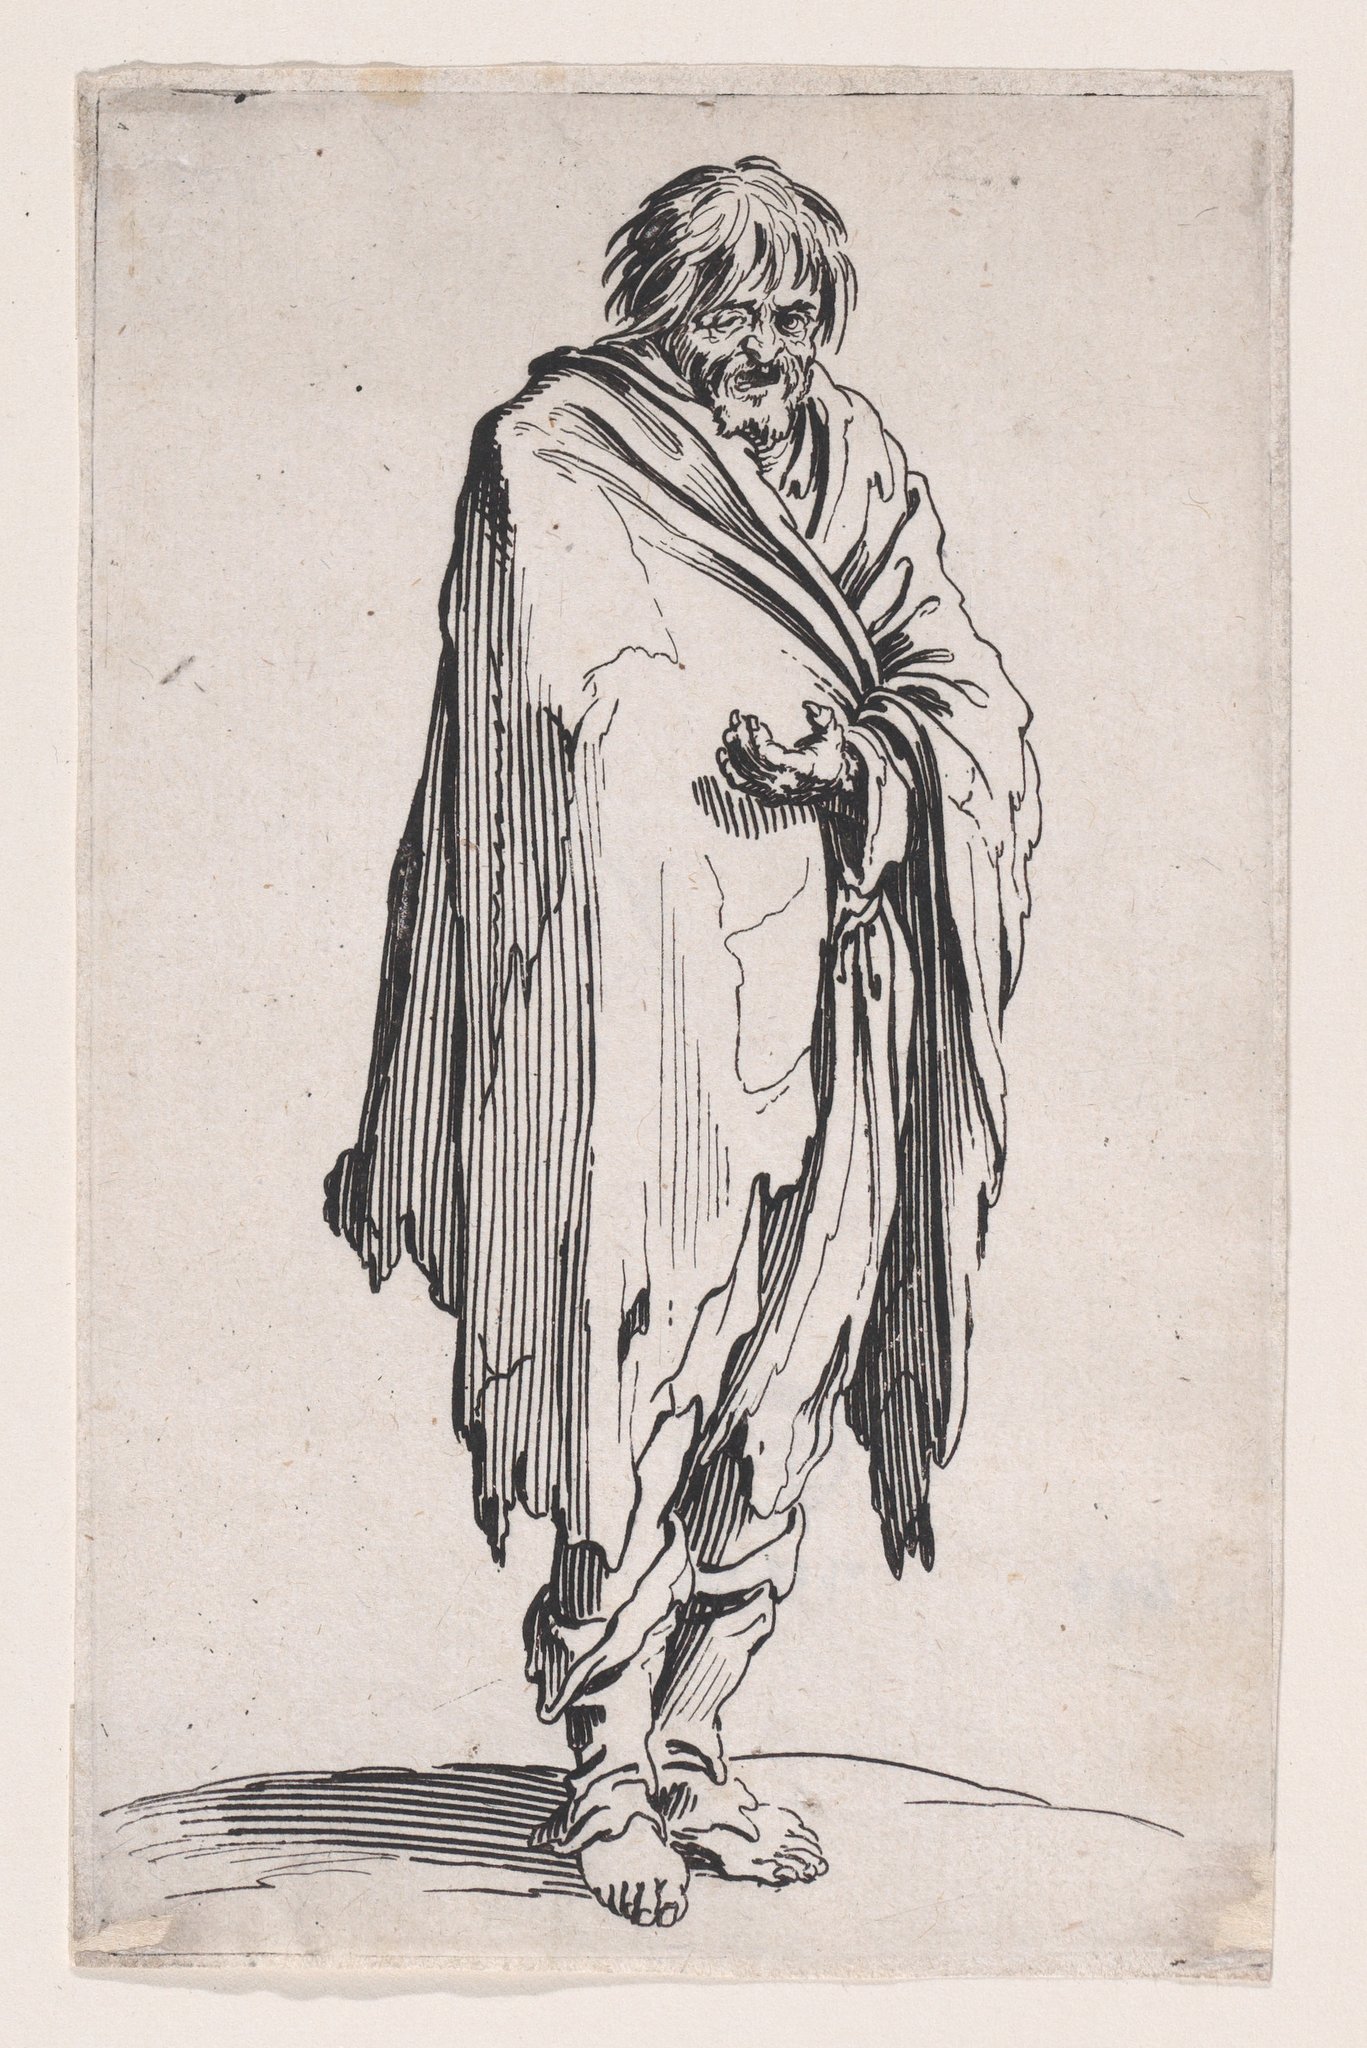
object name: print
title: Le Mendiant a la Tête Découverte et aux Pieds Nuds (The Beggar with the Uncovered Head and Bare Feet), from "Les Gueux suite appelée aussi Les Mendiants, Les Baroni, ou Les Barons" (The Beggars, also called the Barons)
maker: jacques callot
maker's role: artist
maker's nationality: french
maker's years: 1592-1635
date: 1623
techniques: etching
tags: men